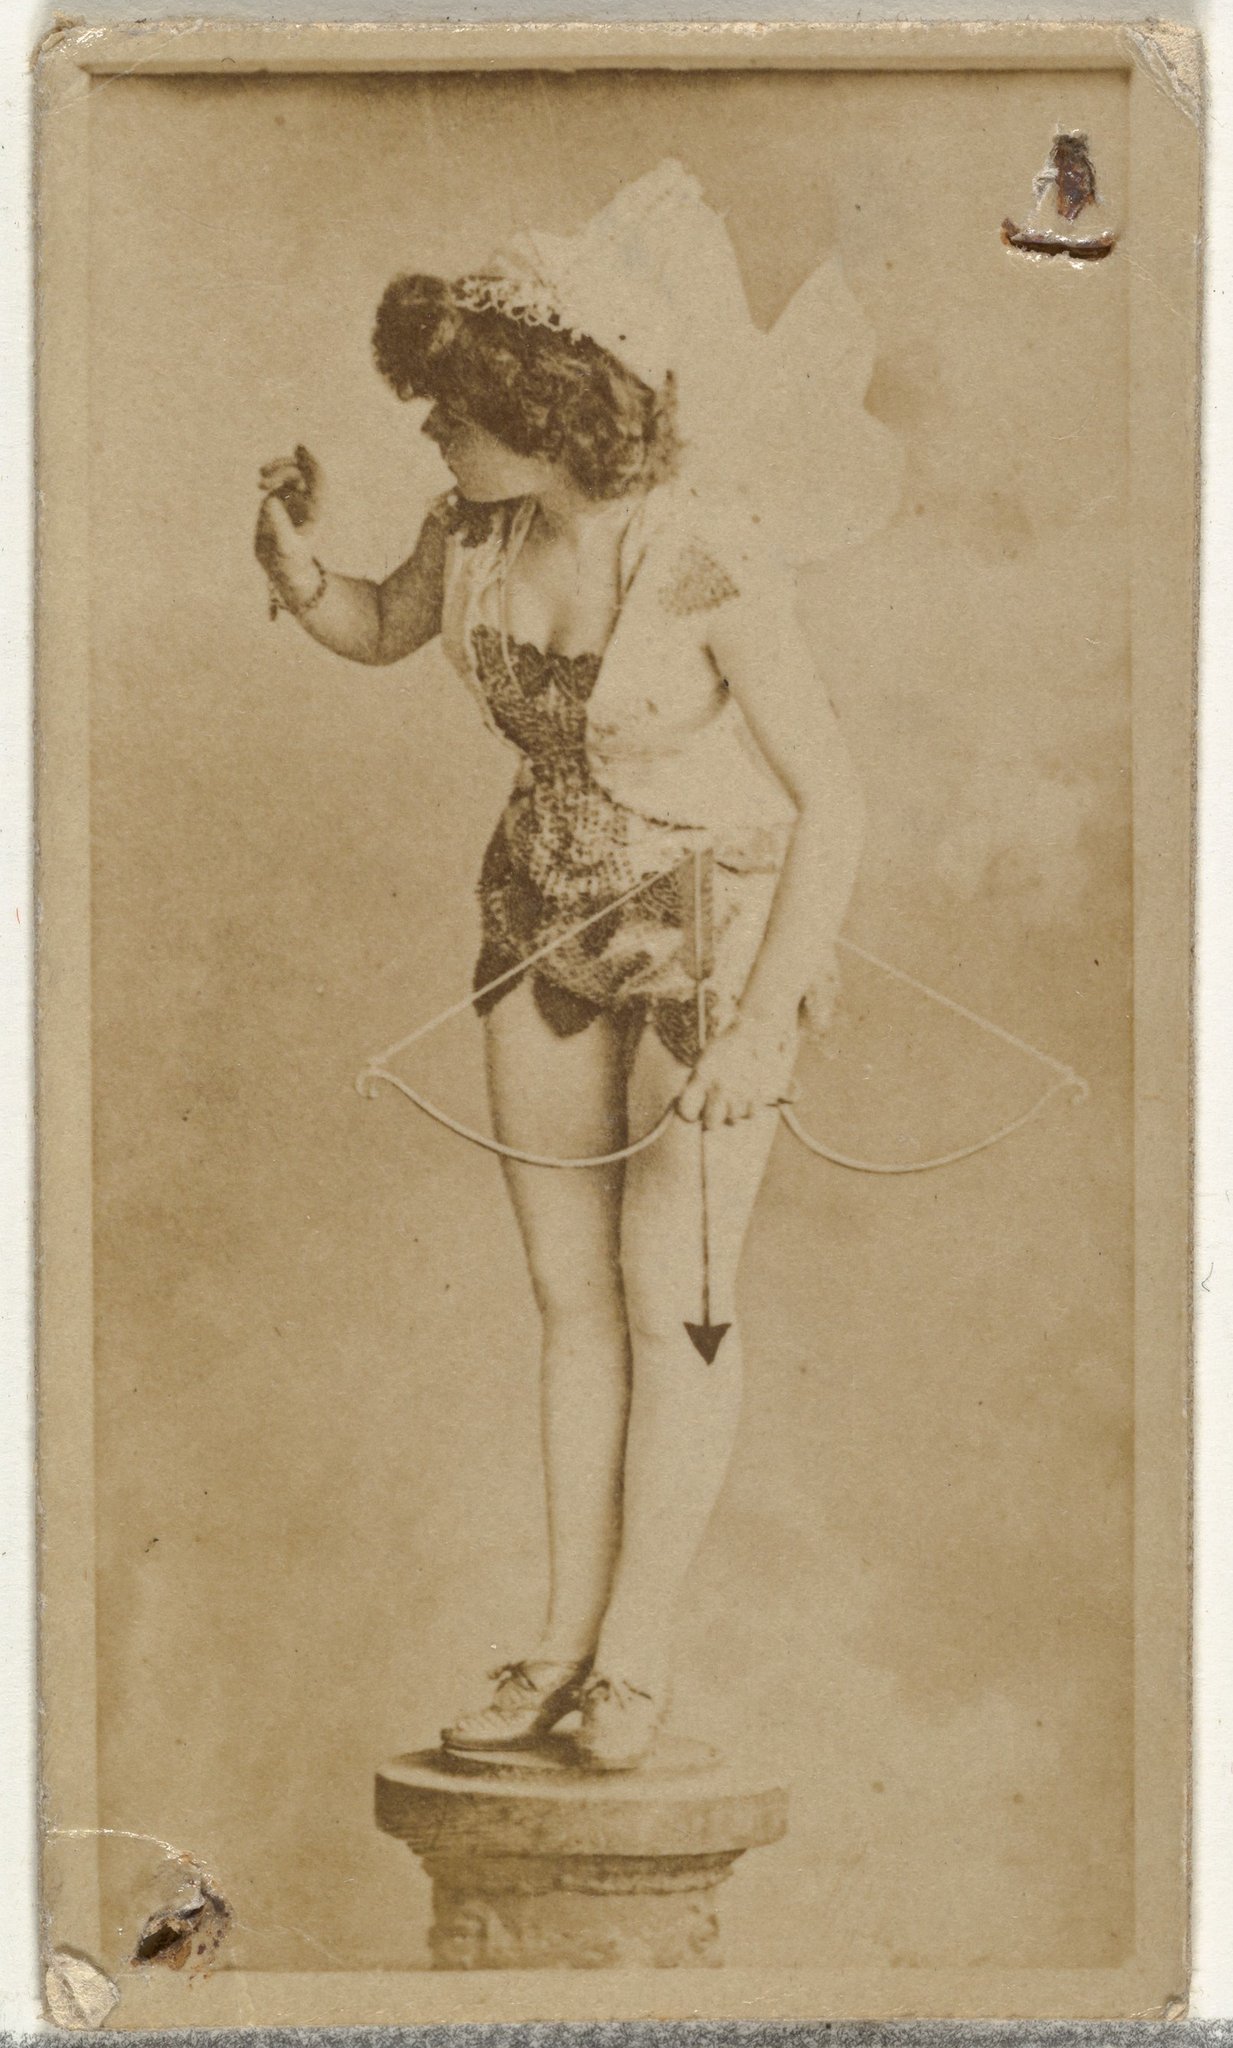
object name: photograph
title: [Actress dressed as cupid perched on prop column], from the Actors and Actresses series (N145-8) issued by Duke Sons & Co. to promote Duke Cigarettes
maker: w. duke, sons & co.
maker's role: publisher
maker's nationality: american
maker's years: 1870-1920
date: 1891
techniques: albumen silver print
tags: profiles,women,actresses